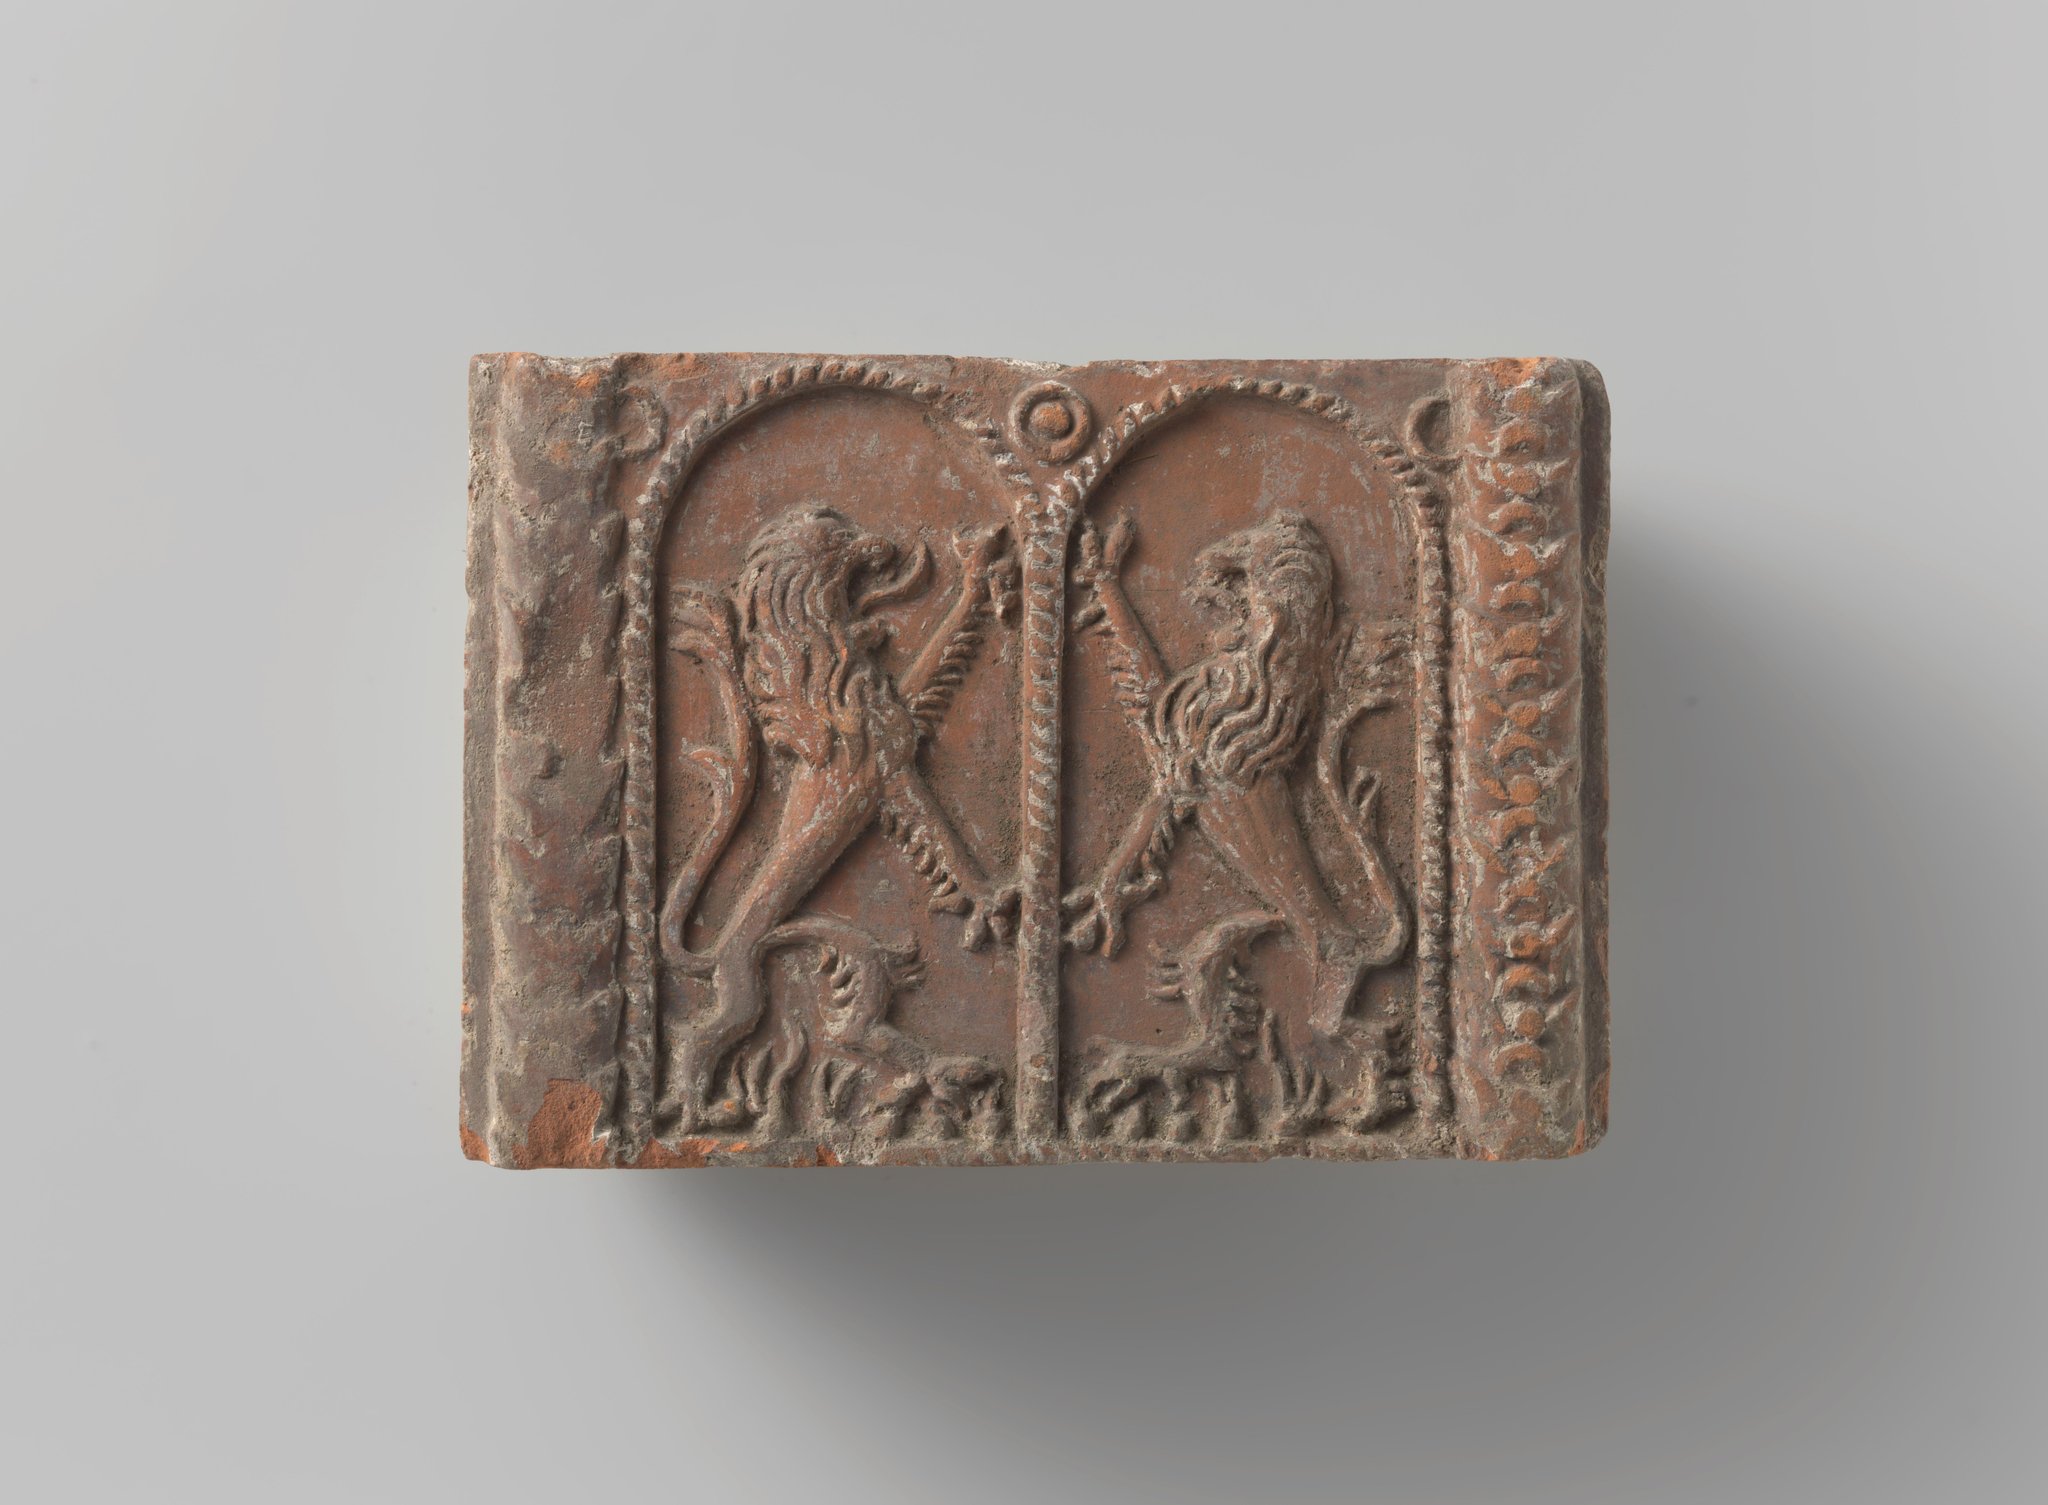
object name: hearthstone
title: Haardsteen met voorstelling van twee klimmende leeuwen, geplaatst in twee nissen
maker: Anonymous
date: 1500-1600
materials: earthenware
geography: southern netherlands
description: Haardsteen met voorstelling van twee klimmende leeuwen, geplaatst in twee nissen.